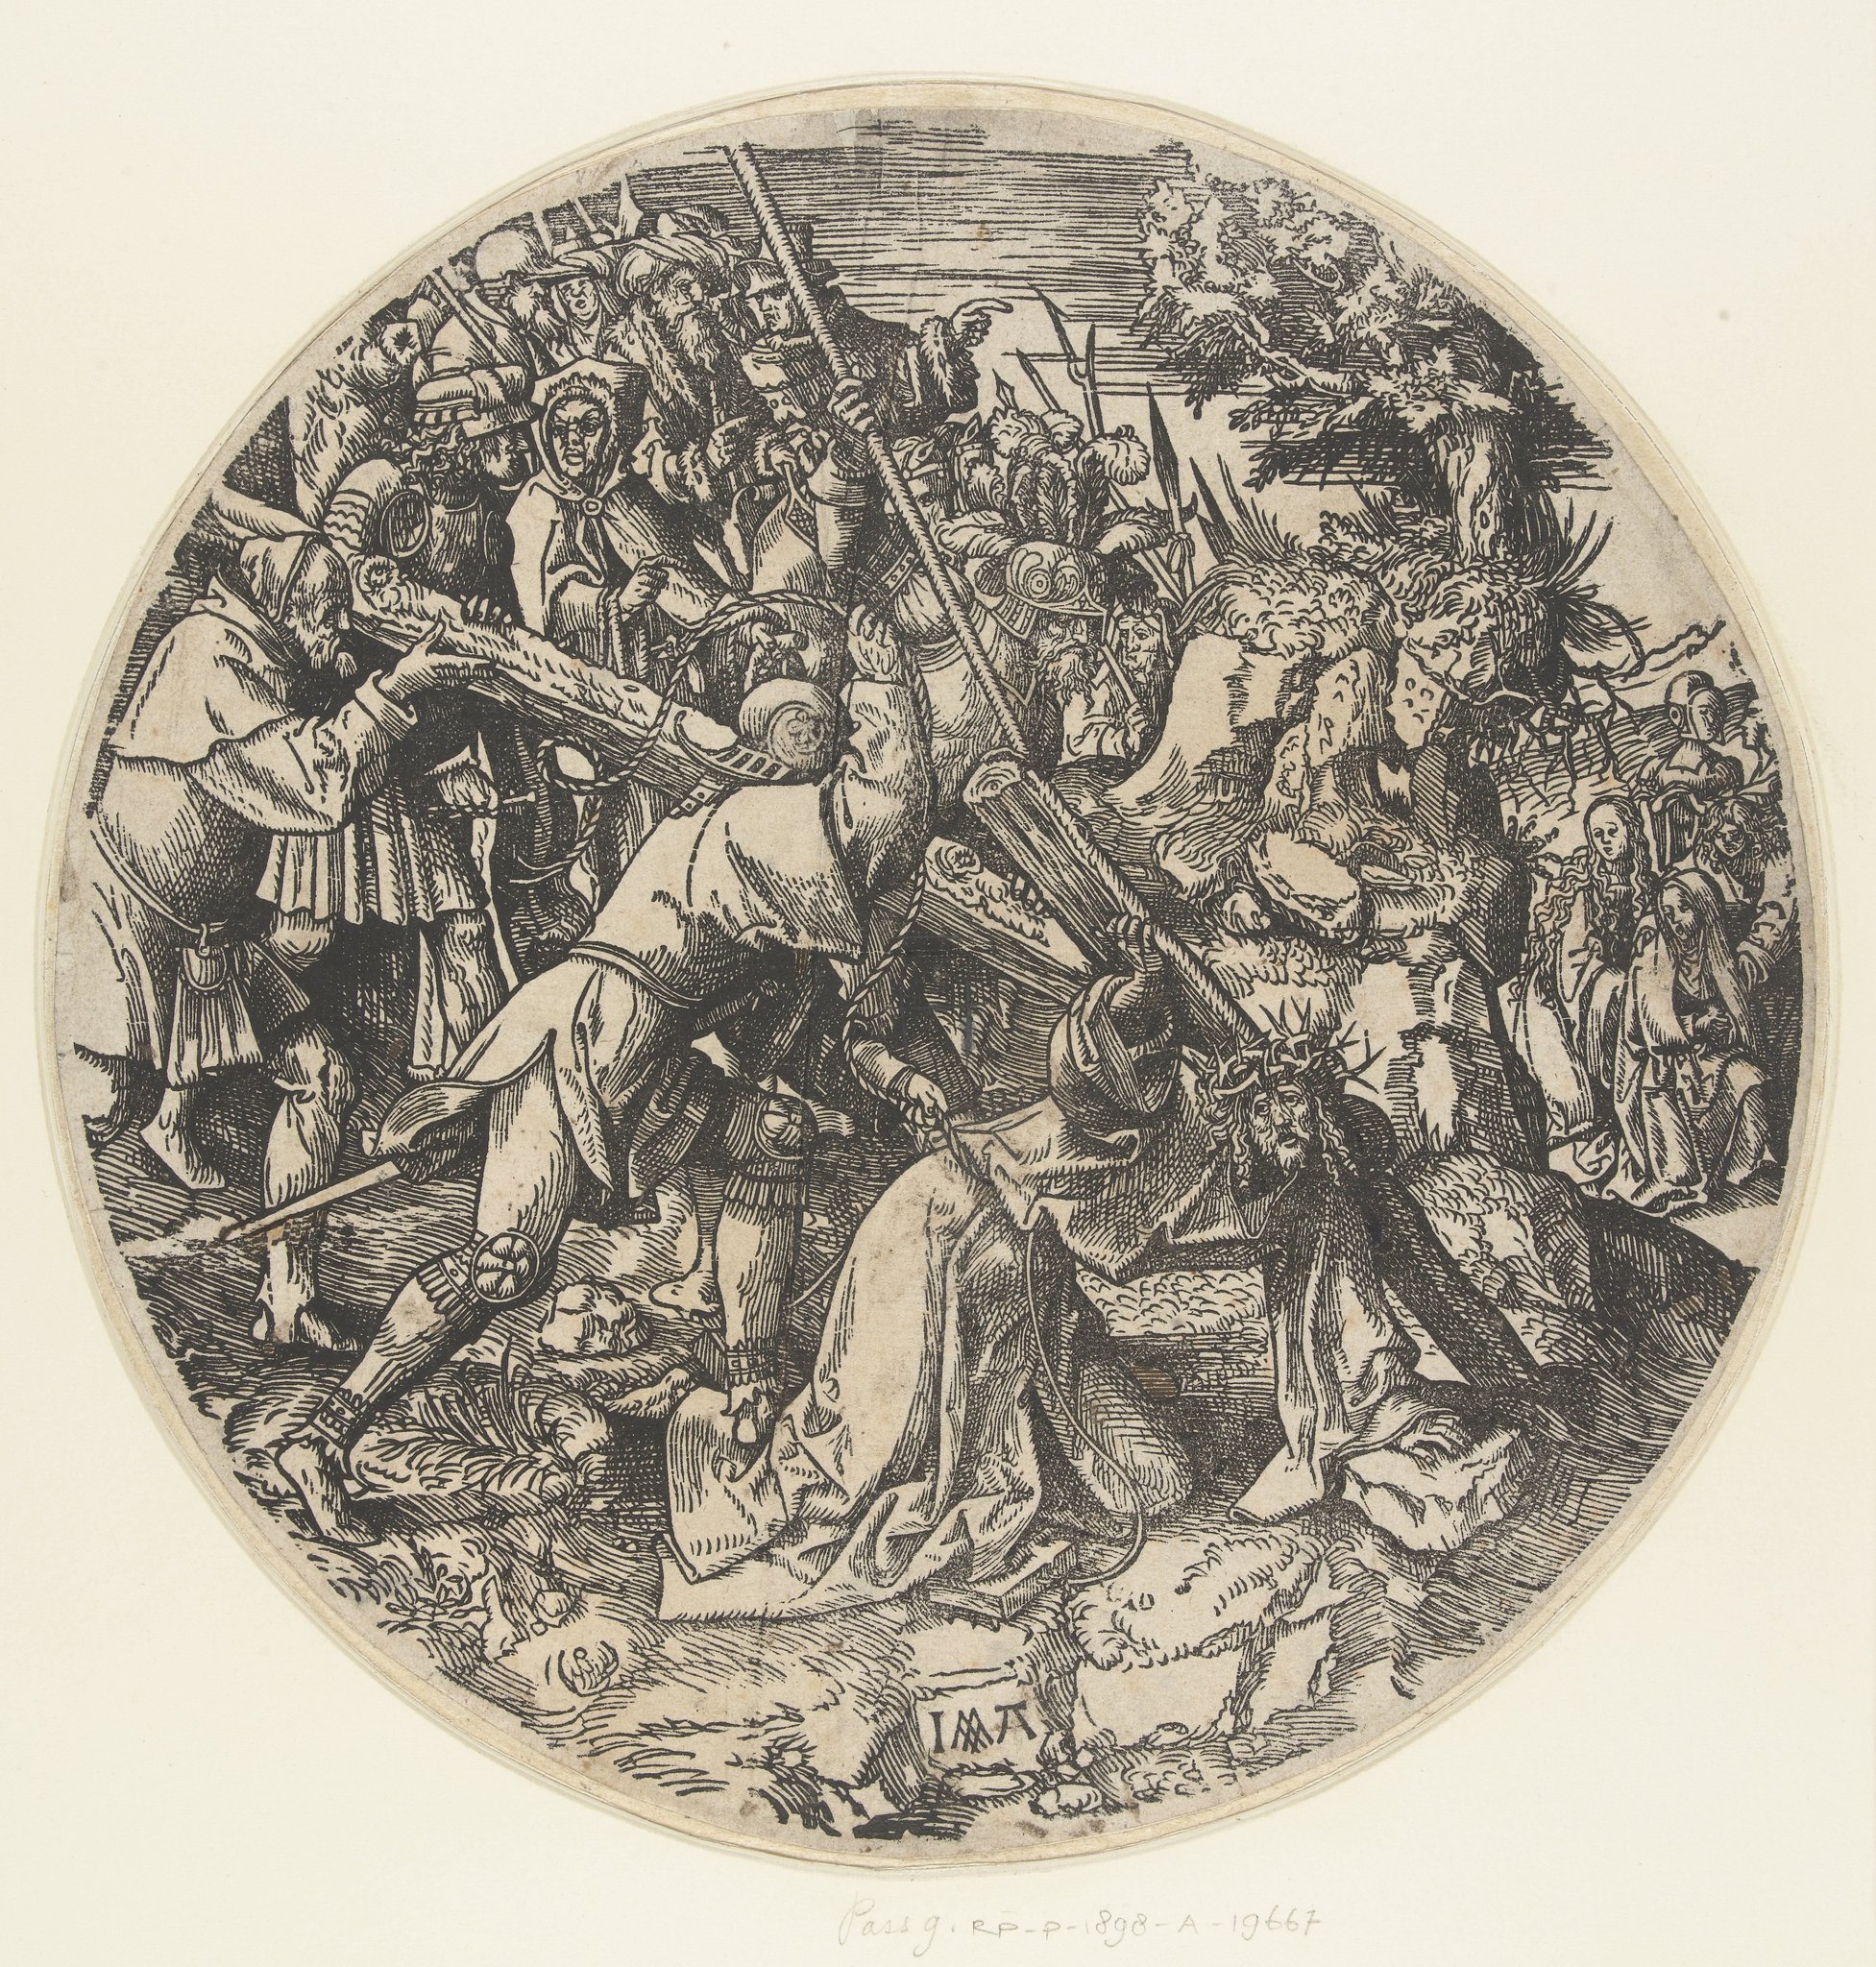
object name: print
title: Kruisdraging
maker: jacob cornelisz van oostsanen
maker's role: draughtsman, painter, print maker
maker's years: 1475-1533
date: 1517-1533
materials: paper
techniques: woodcut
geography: low countries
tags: christ collapsing ~ carrying of the cross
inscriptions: collector's mark: Lugt 2228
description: Uit serie van twaalf prenten, omlijsting weggesneden.